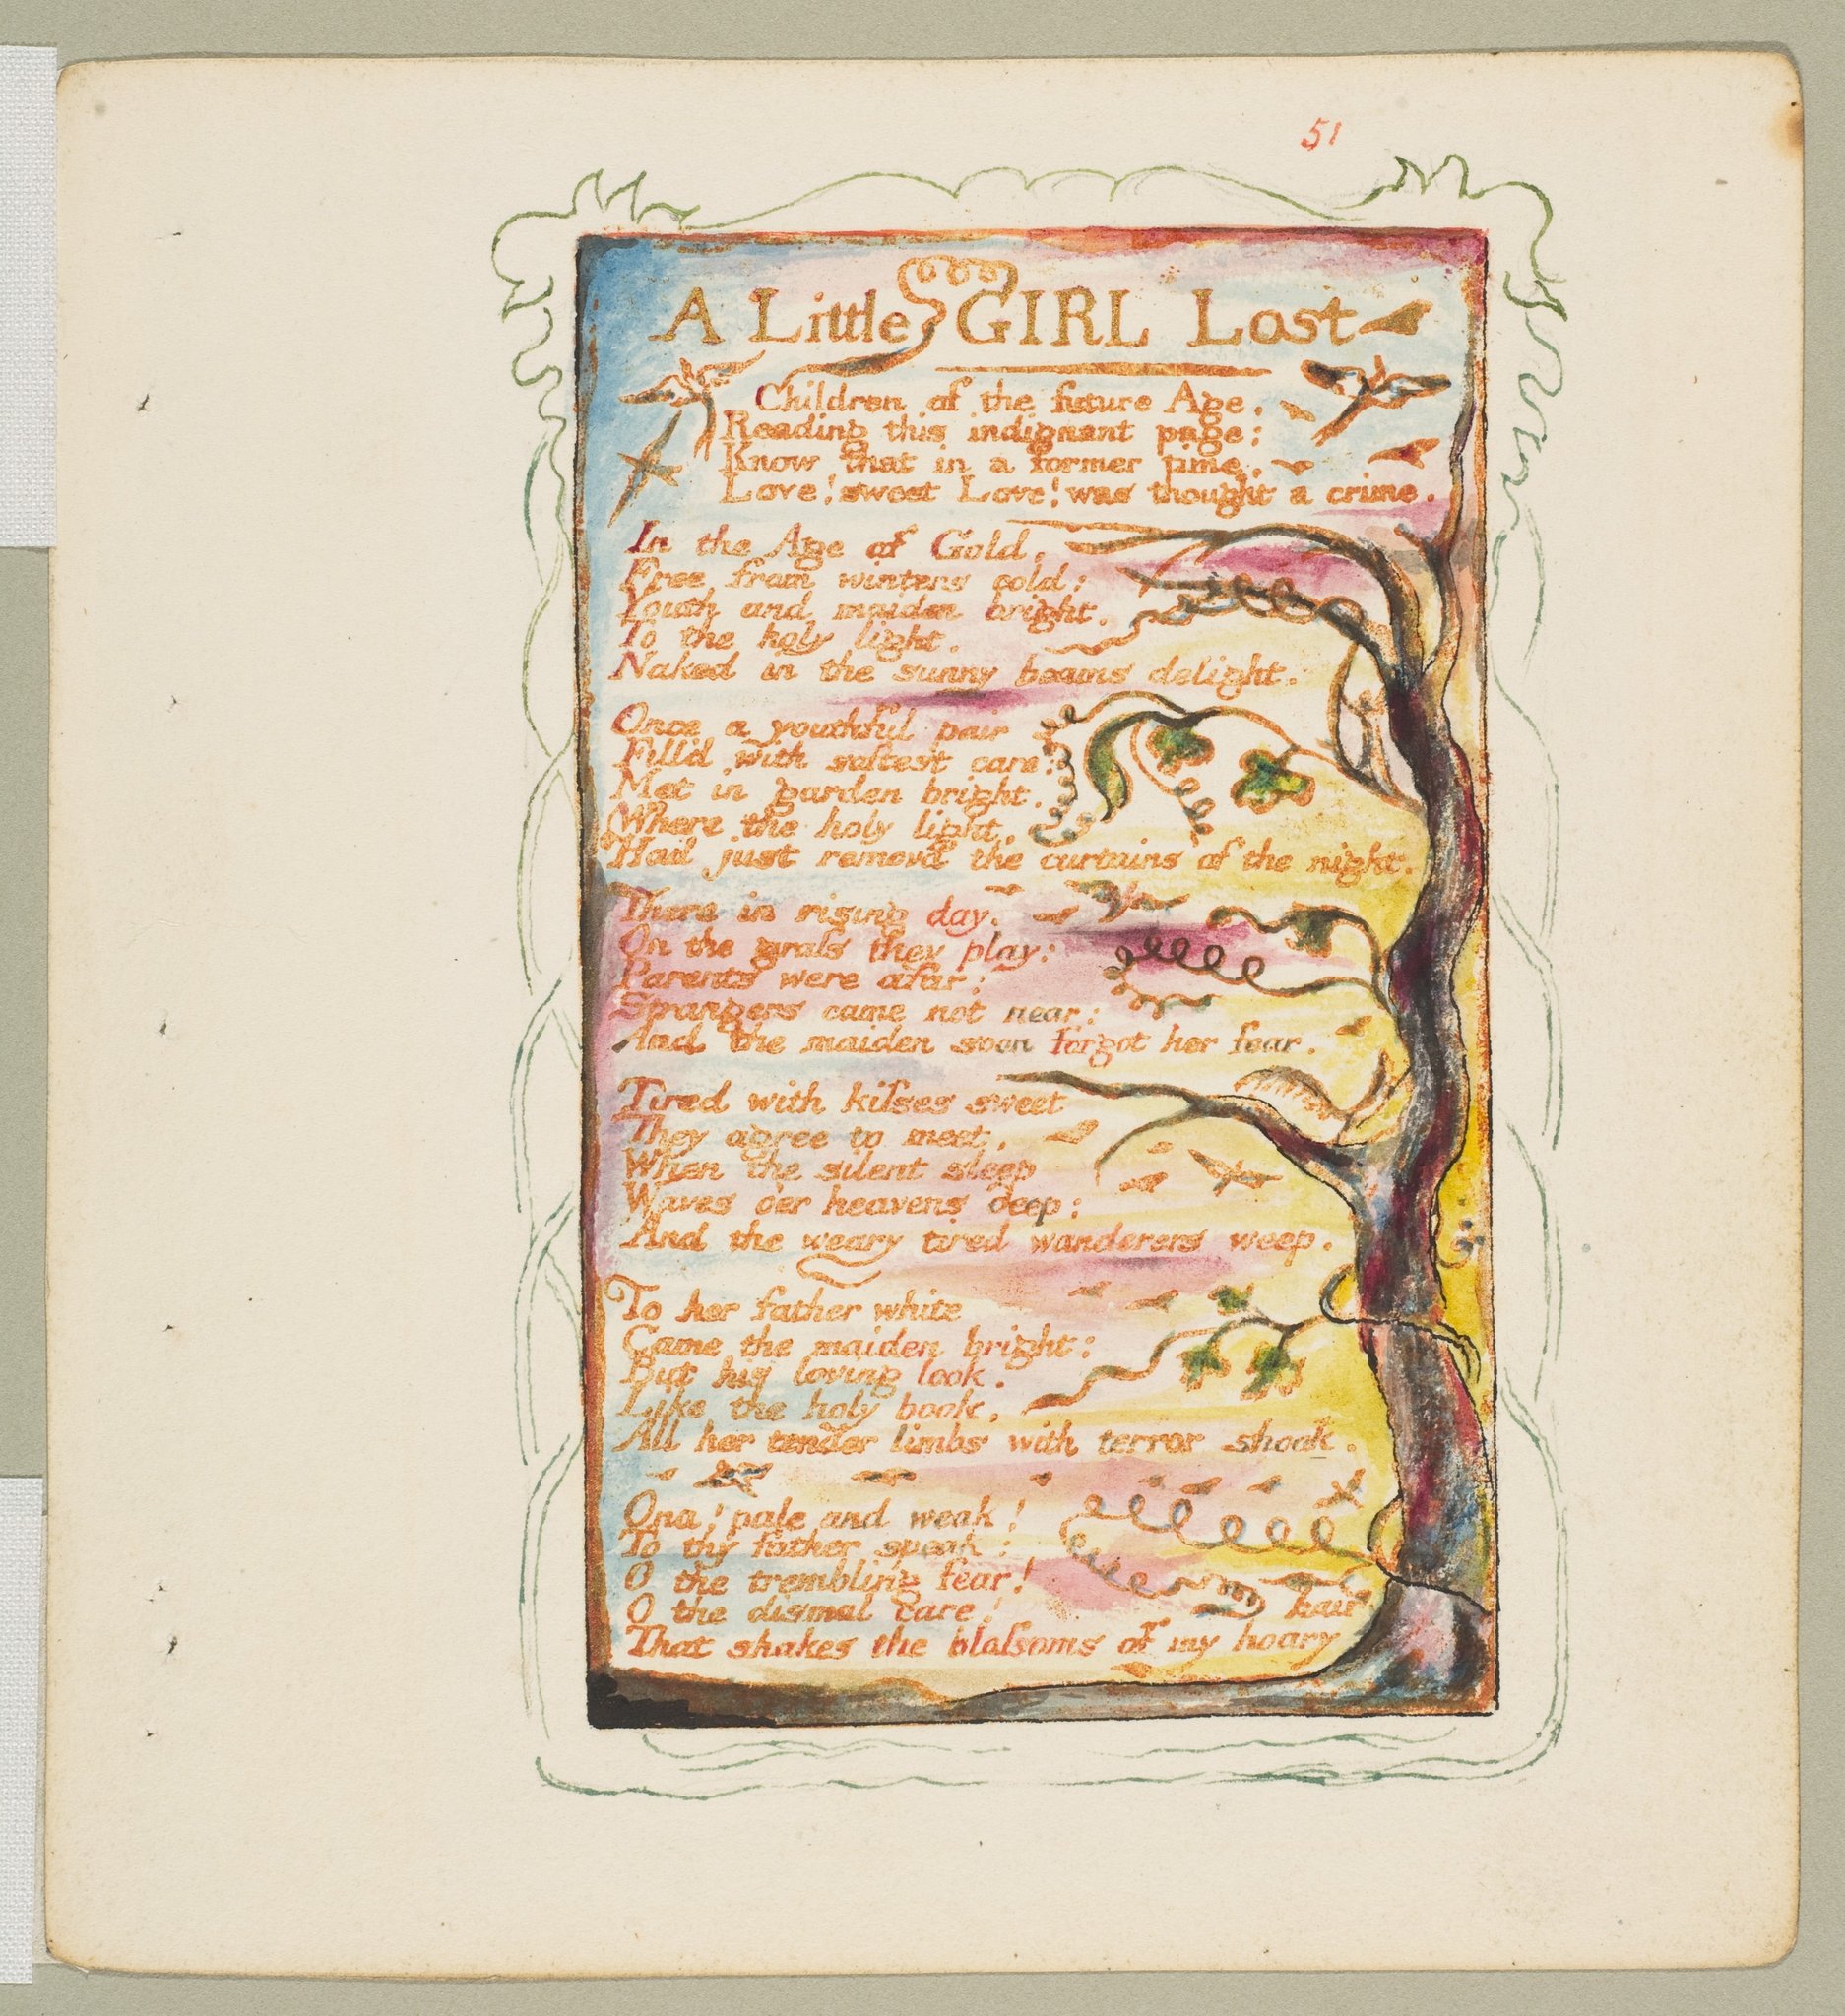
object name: print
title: Songs of Experience: A Little Girl Lost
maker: william blake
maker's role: artist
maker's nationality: british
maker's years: 1757-1827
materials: gold, ink, shell, watercolor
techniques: etching, hand coloring, printing, relief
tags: poetry